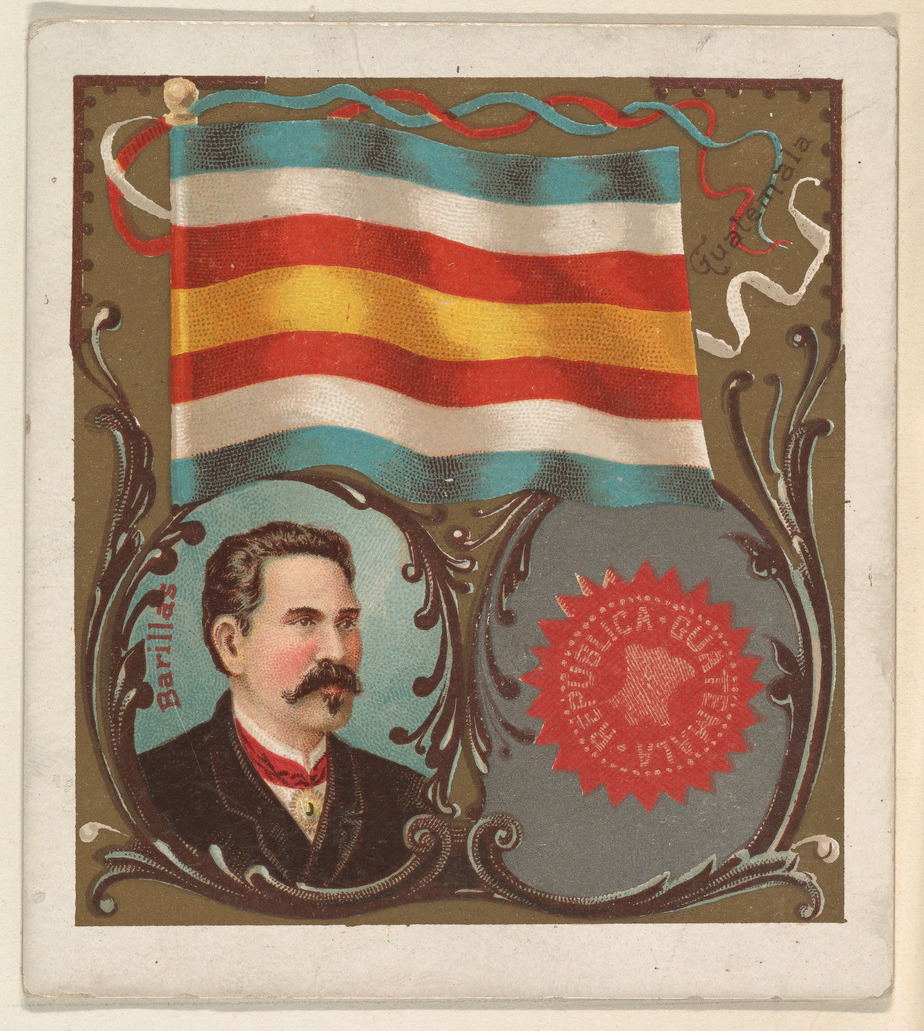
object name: print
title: Guatemala, from the International Cards series (N238), issued by Kinney Bros.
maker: kinney brothers tobacco company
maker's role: publisher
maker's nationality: american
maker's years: 1869-2011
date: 1888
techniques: color lithograph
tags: men,flags